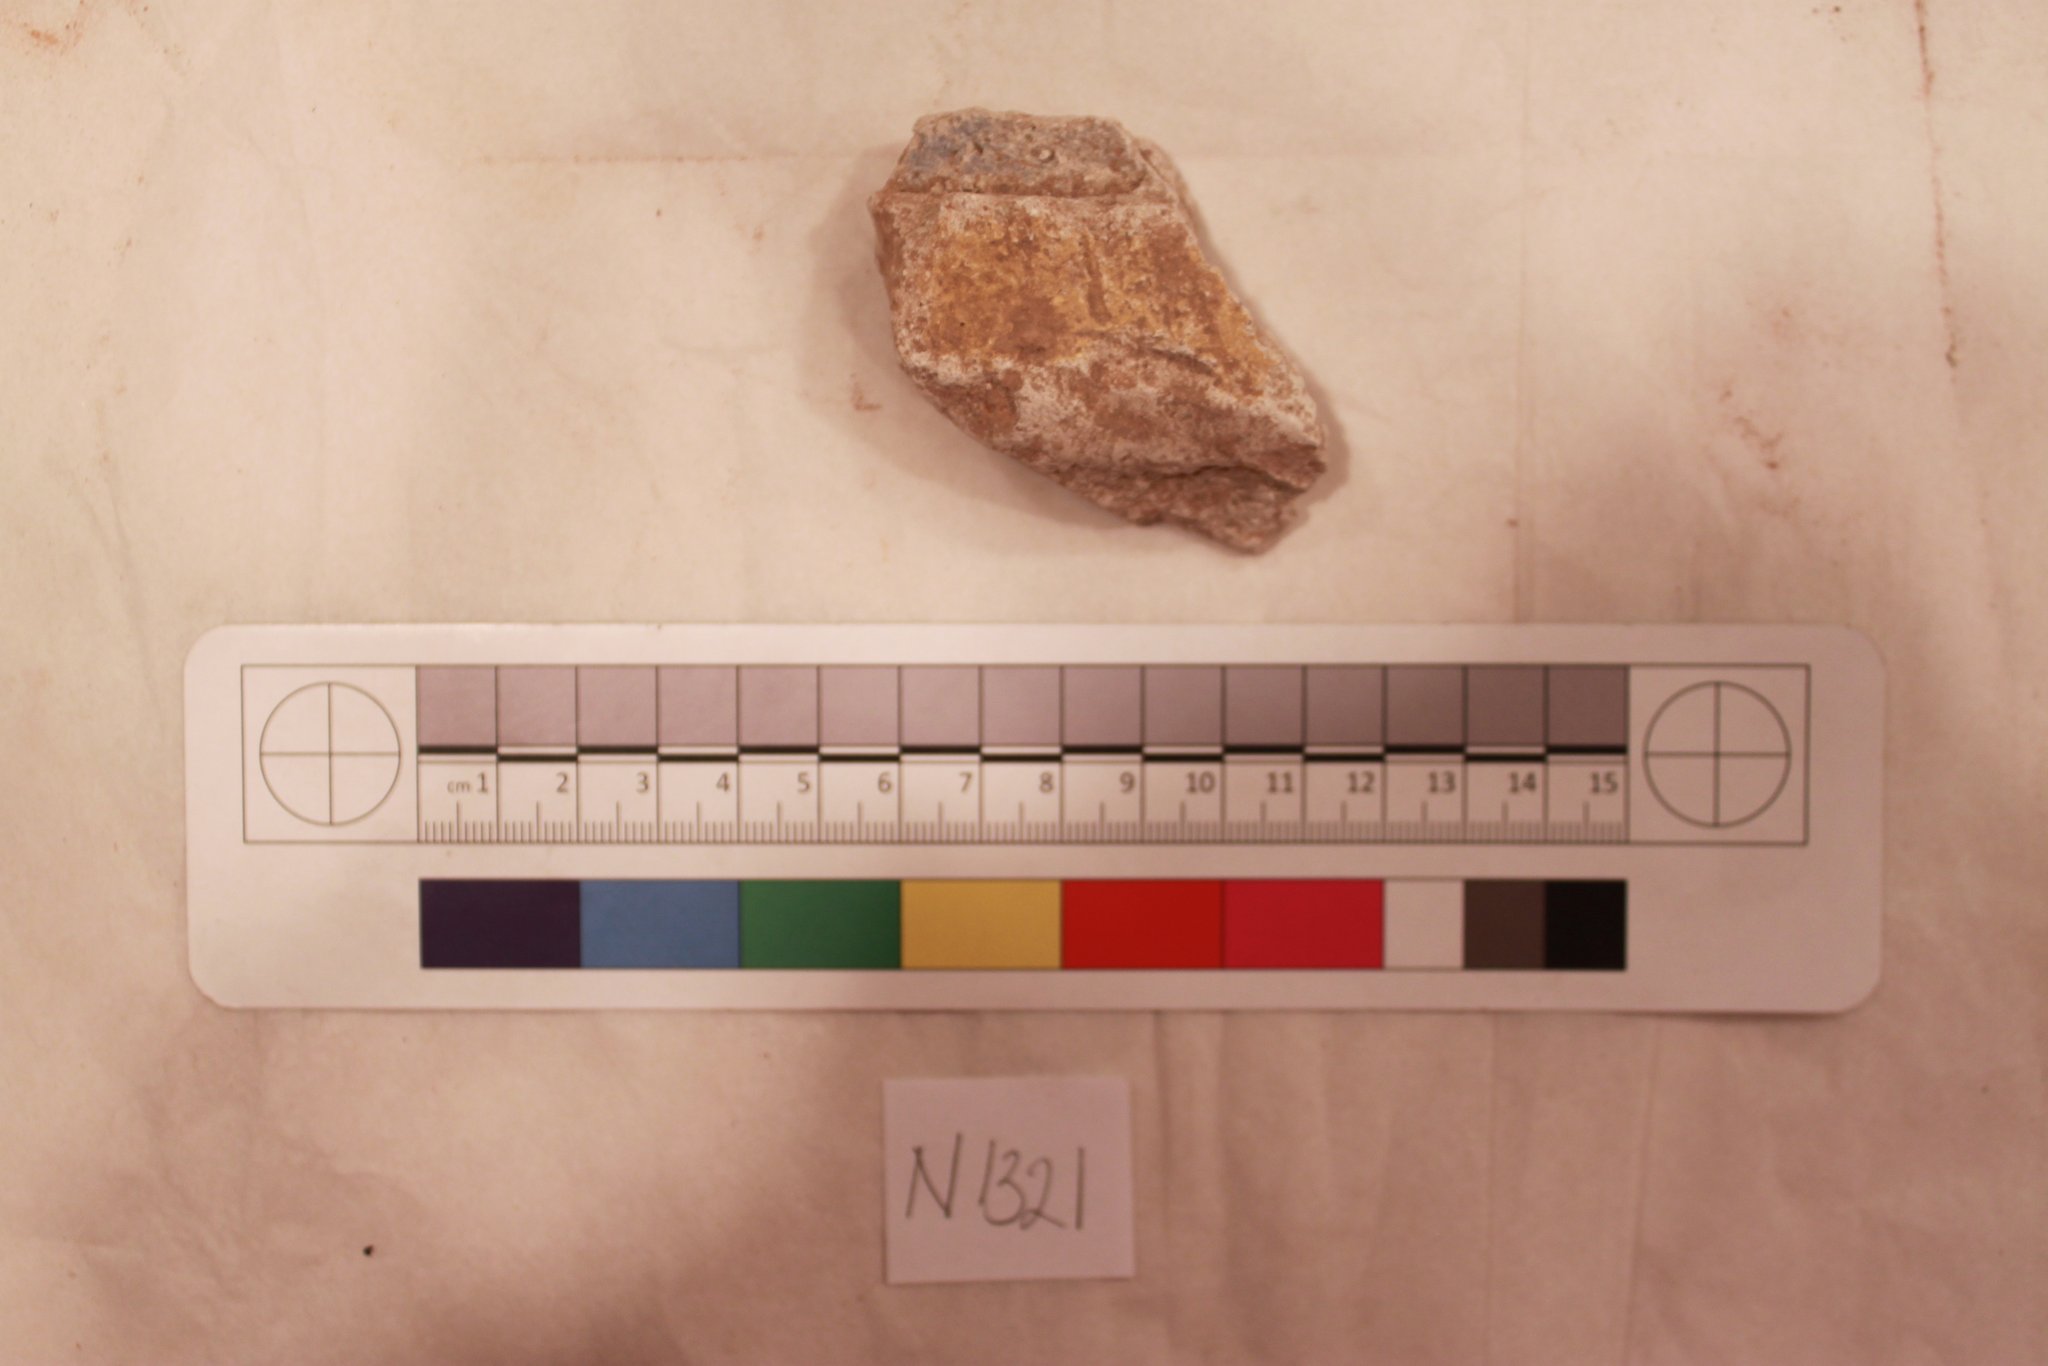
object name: fragment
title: Stucco Fragment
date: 701-1200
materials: plaster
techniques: carving, painting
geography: iran